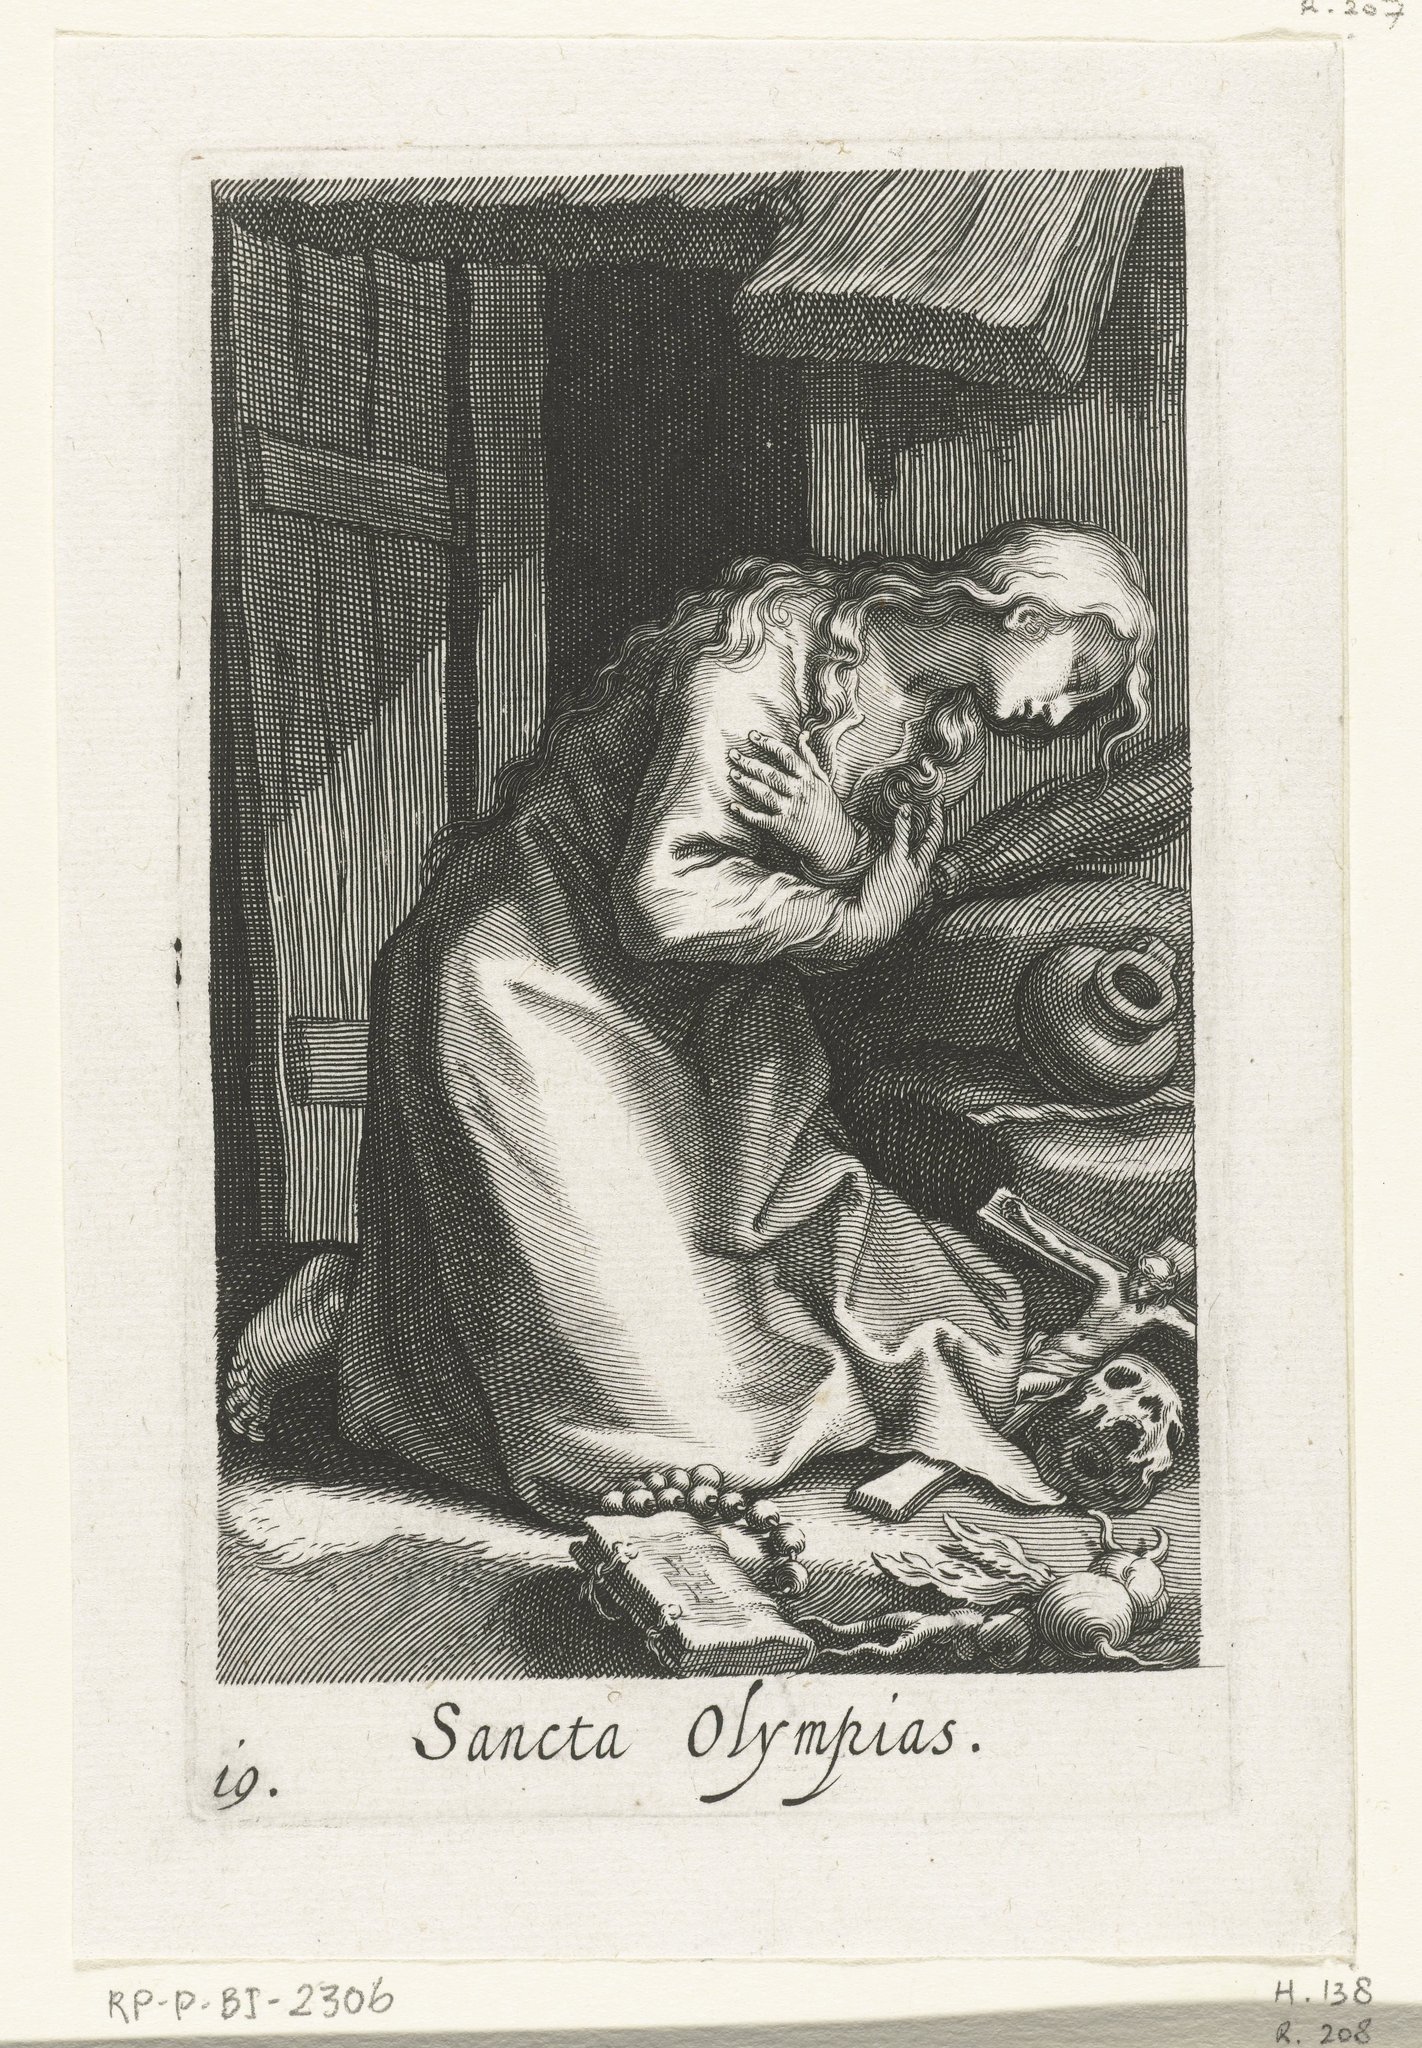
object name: book illustration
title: Kluizenaressen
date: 1590-1612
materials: paper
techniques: engraving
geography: antwerp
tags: anchorite, hermit, female saints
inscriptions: collector's mark: Lugt 2228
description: Kopie in spiegelbeeld naar prent van Boëtius Adamsz. Bolswert uit serie Kluizenaressen.